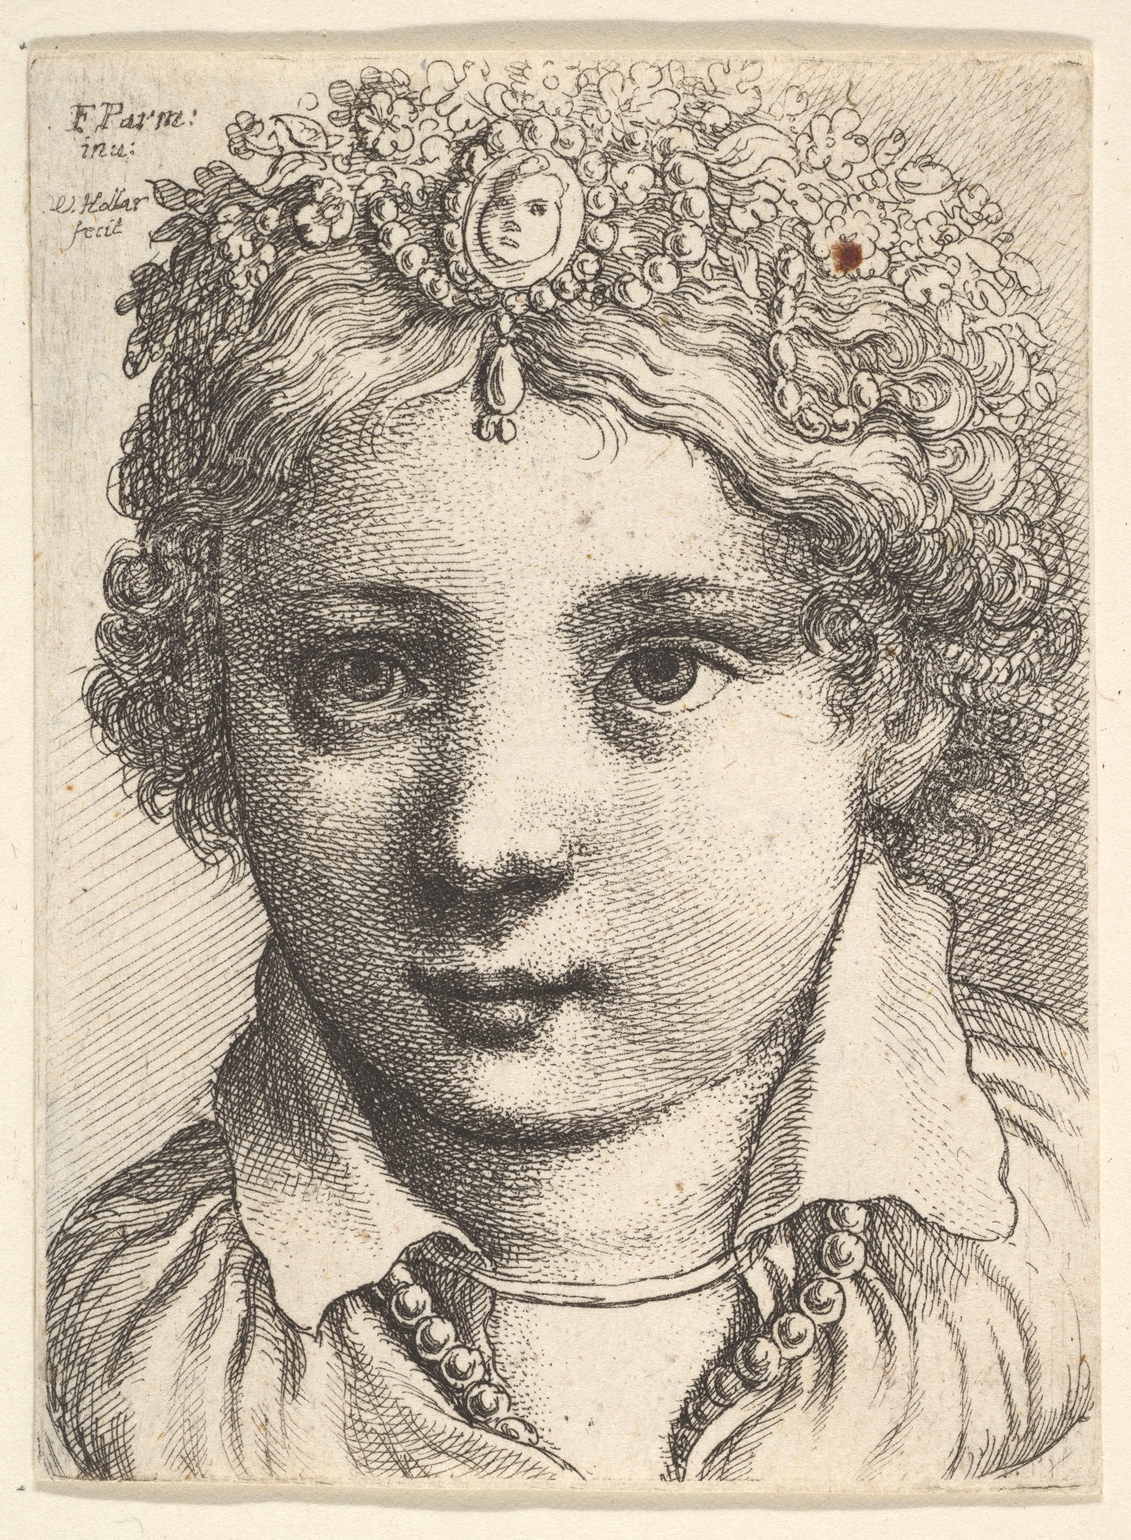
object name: print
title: Head of a young girl wearing a jeweled headdress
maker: wenceslaus hollar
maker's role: artist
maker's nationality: bohemian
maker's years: 1607-1677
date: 1645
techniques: etching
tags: jewelry,girls,portraits